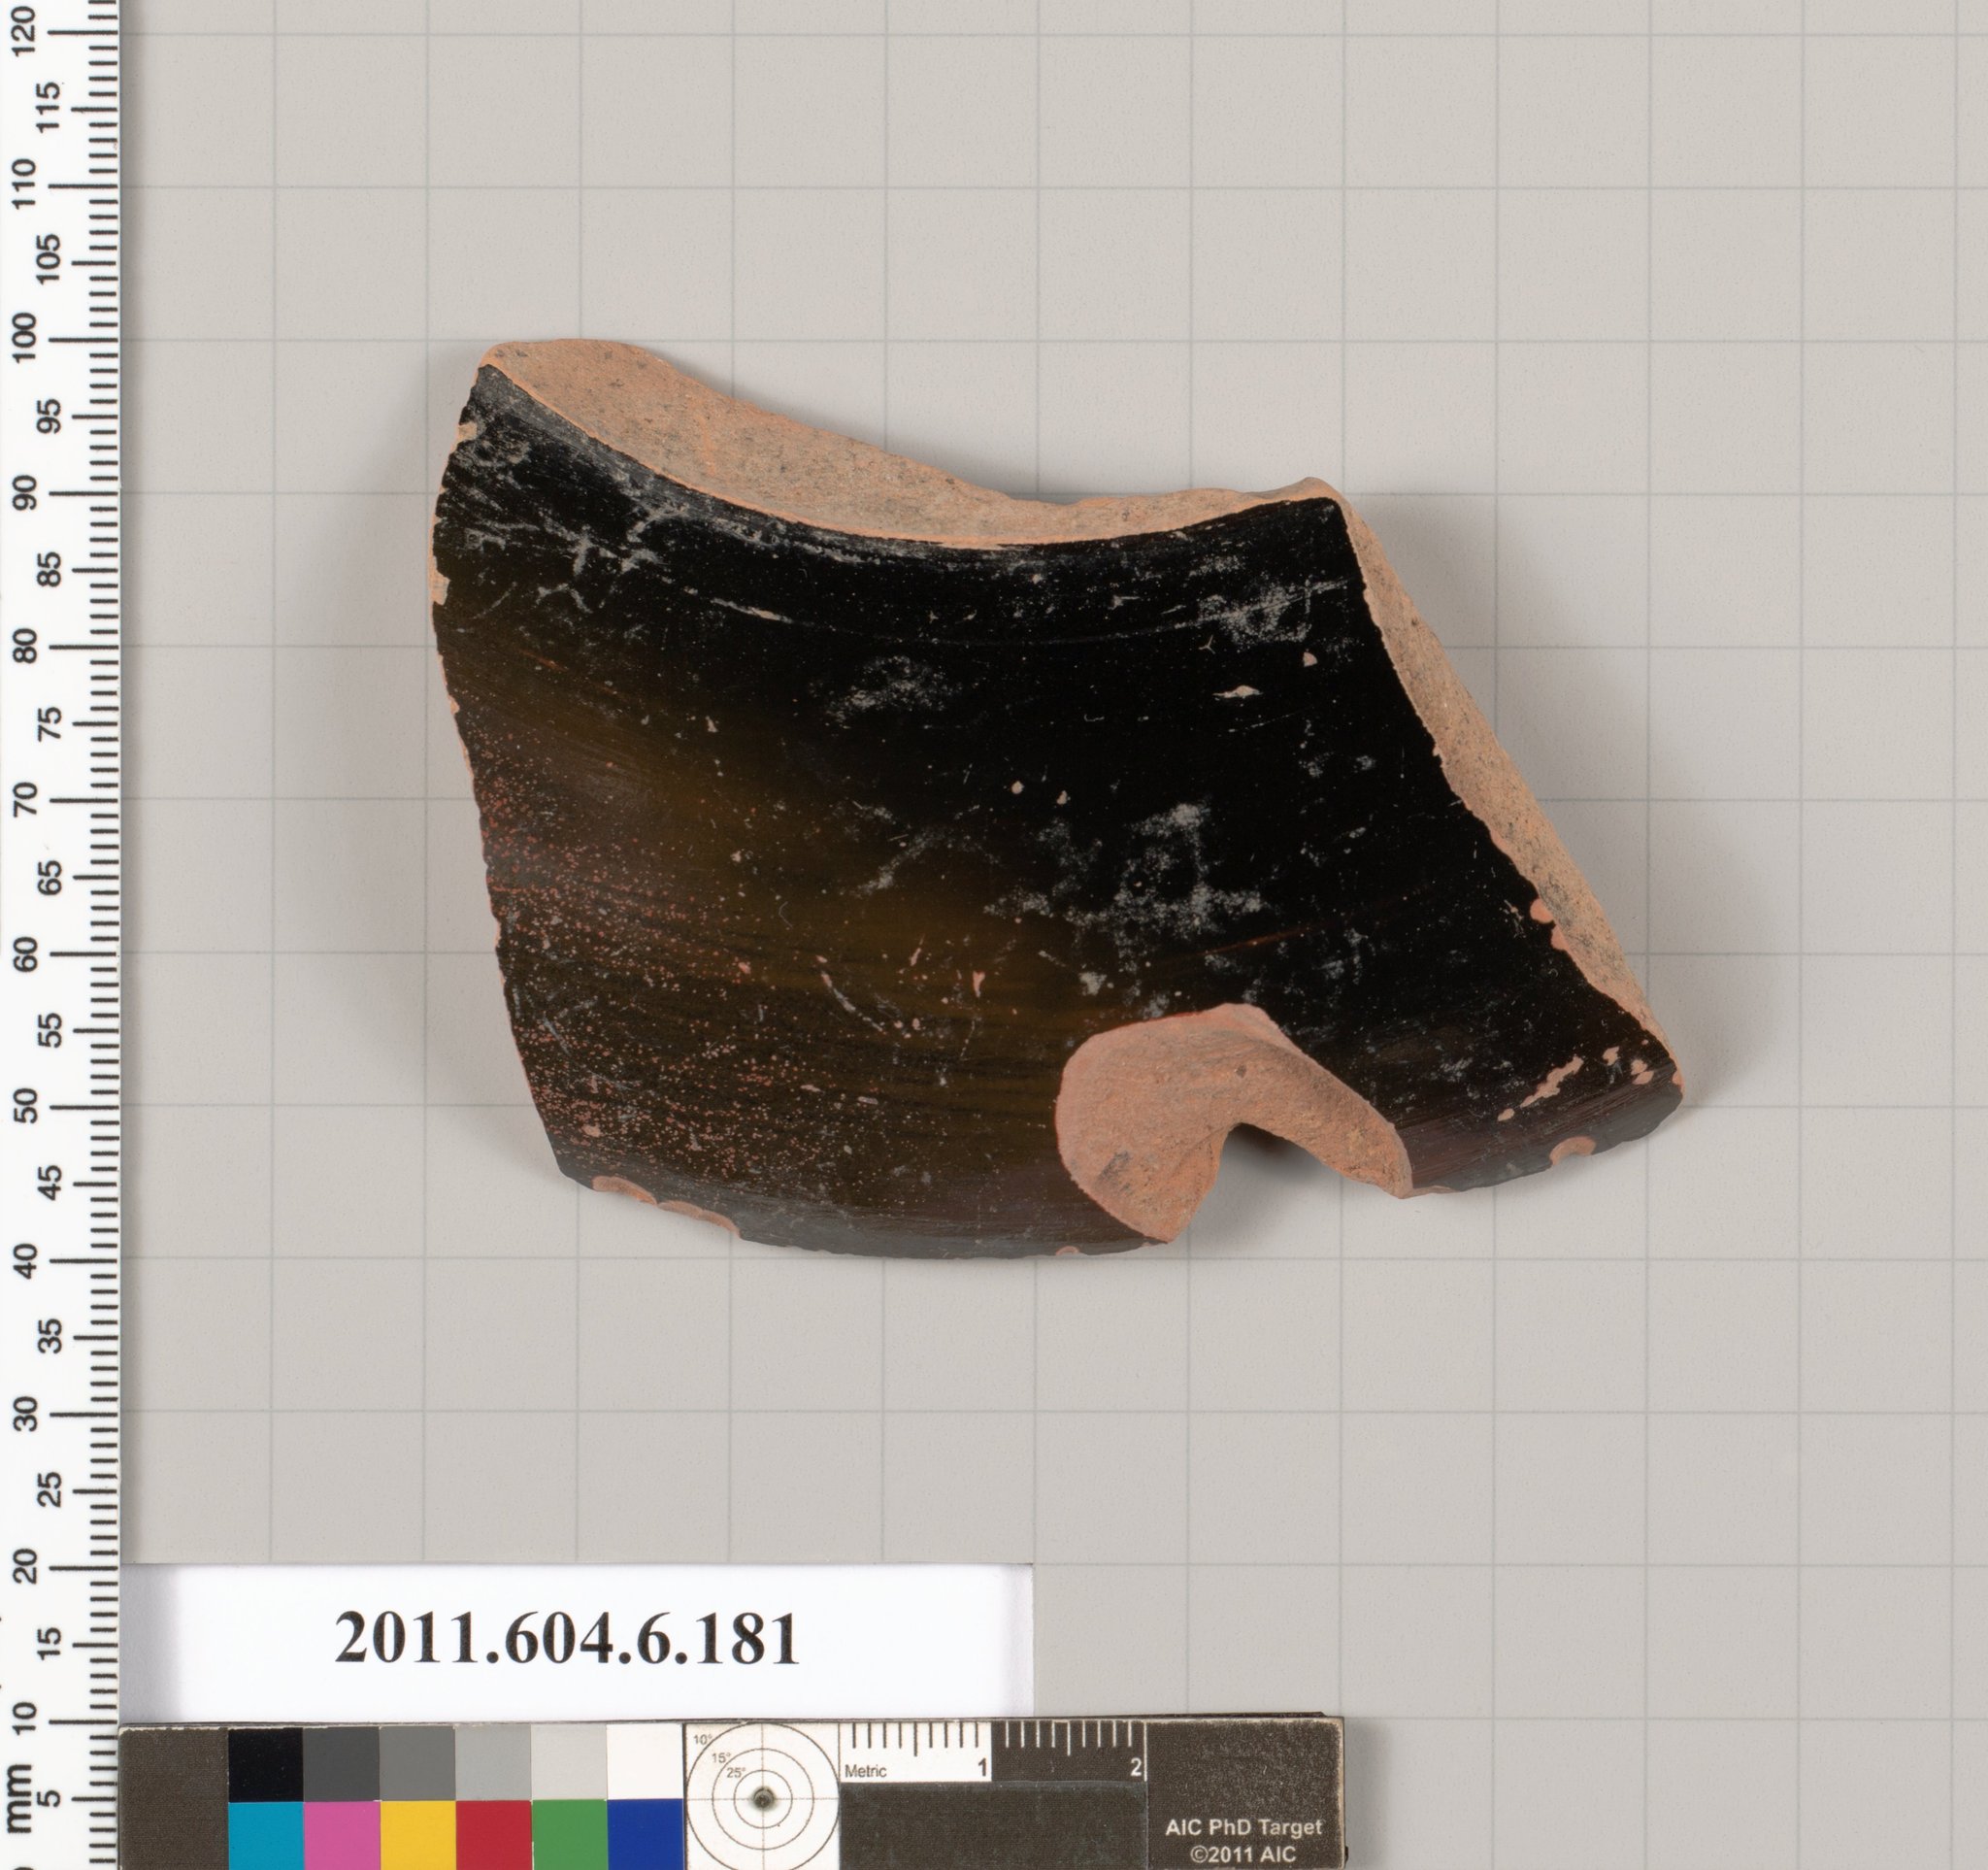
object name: kalpis fragment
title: Terracotta fragment of a kalpis (water jar)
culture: greek, attic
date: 500-401 BCE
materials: terracotta